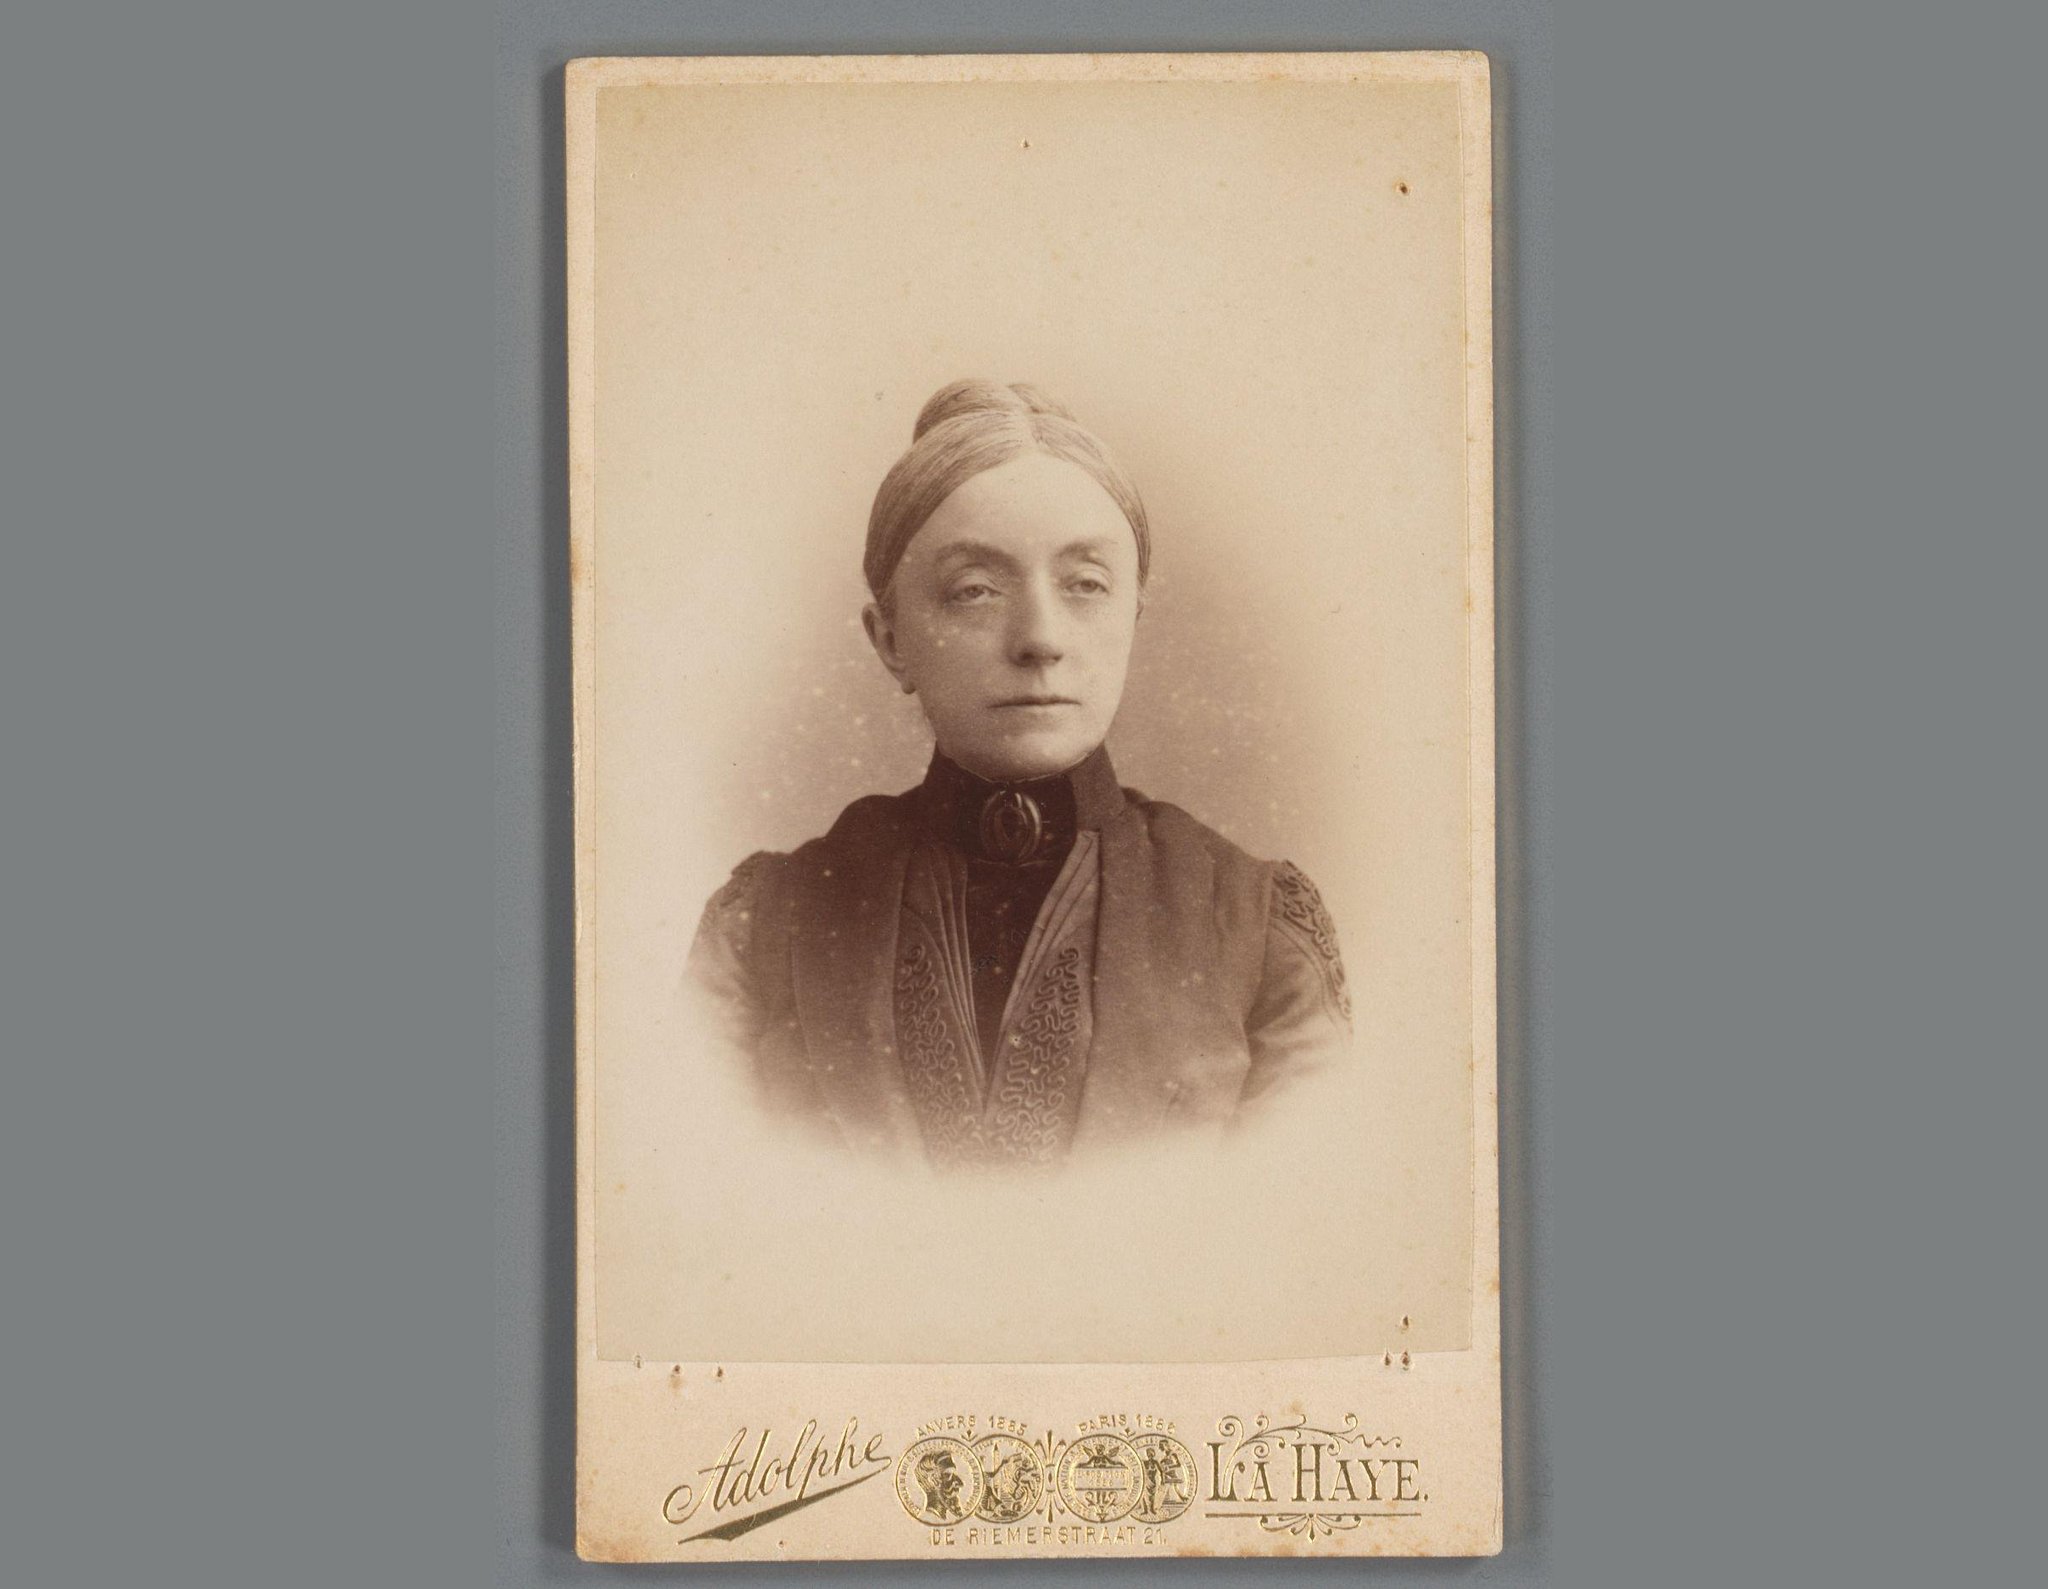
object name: photograph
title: Portret van een onbekende vrouw, mogelijk een lid van de familie Onnen-van den Berg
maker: adolphe zimmermans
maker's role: fotograaf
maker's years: 1858-1922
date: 1884-1913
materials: cardboard, paper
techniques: albumen print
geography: the hague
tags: anonymous historical person portrayed - bb - woman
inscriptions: inscription: ‘Tante [...]’, address: ‘De Riemerstraat 21./ La Haye.’